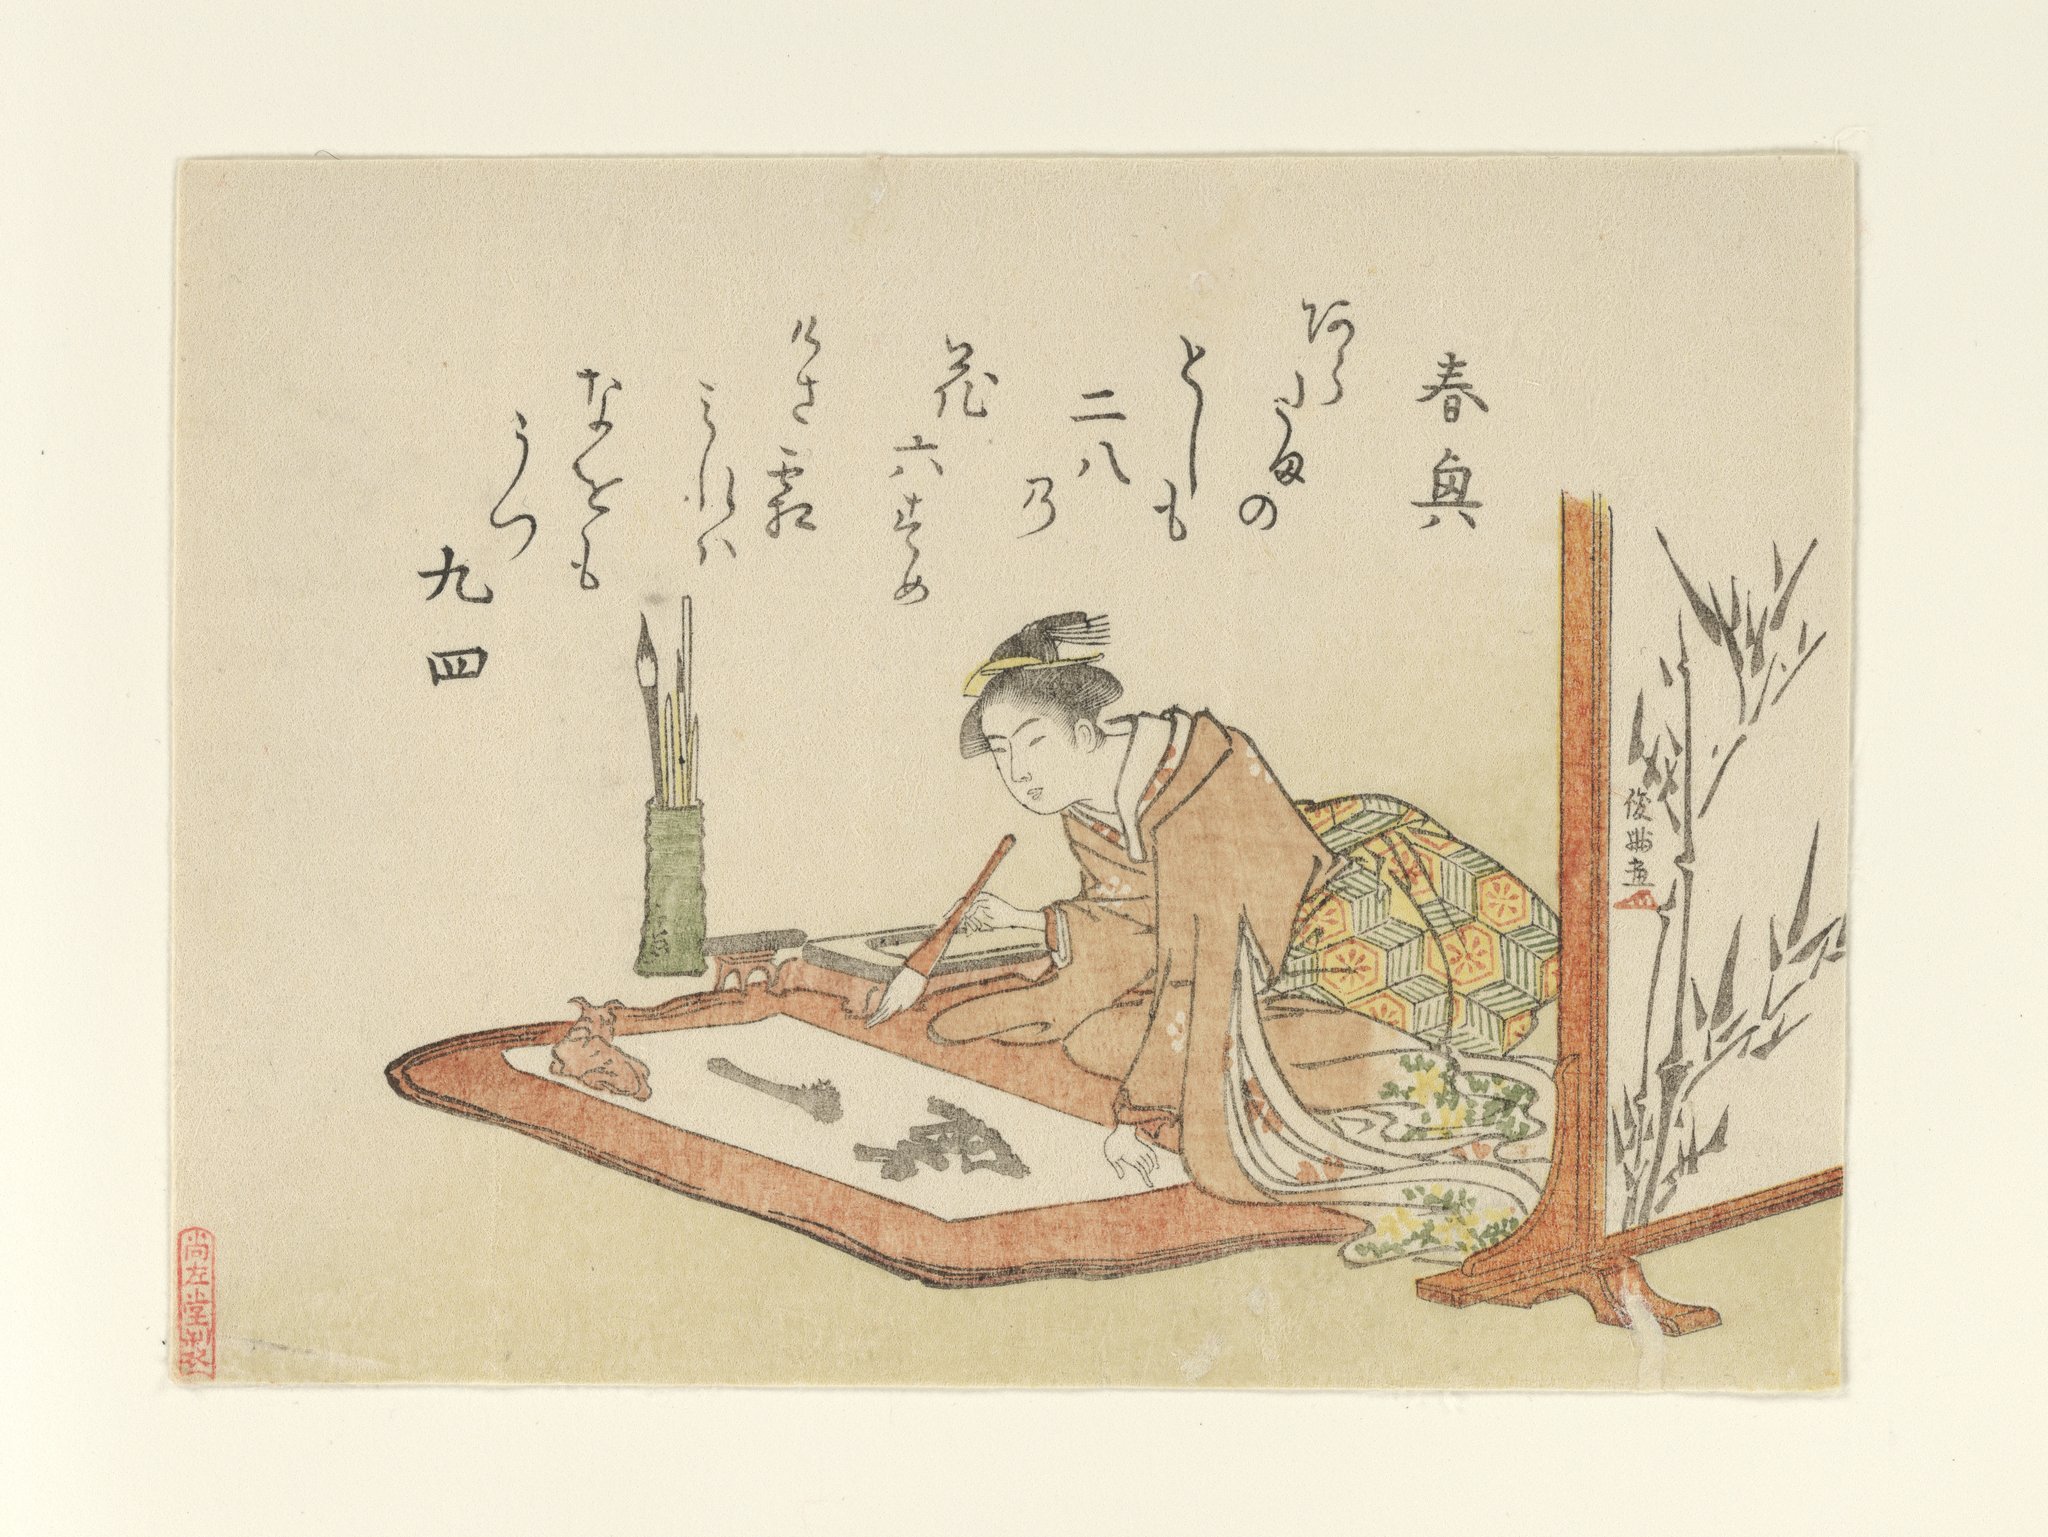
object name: print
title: Young Woman Writing Calligraphy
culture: japanese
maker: kubo shunman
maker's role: artist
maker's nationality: japanese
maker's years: 1757-1820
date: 1793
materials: ink, paper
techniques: surimono, woodblock print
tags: women,writing,calligraphy